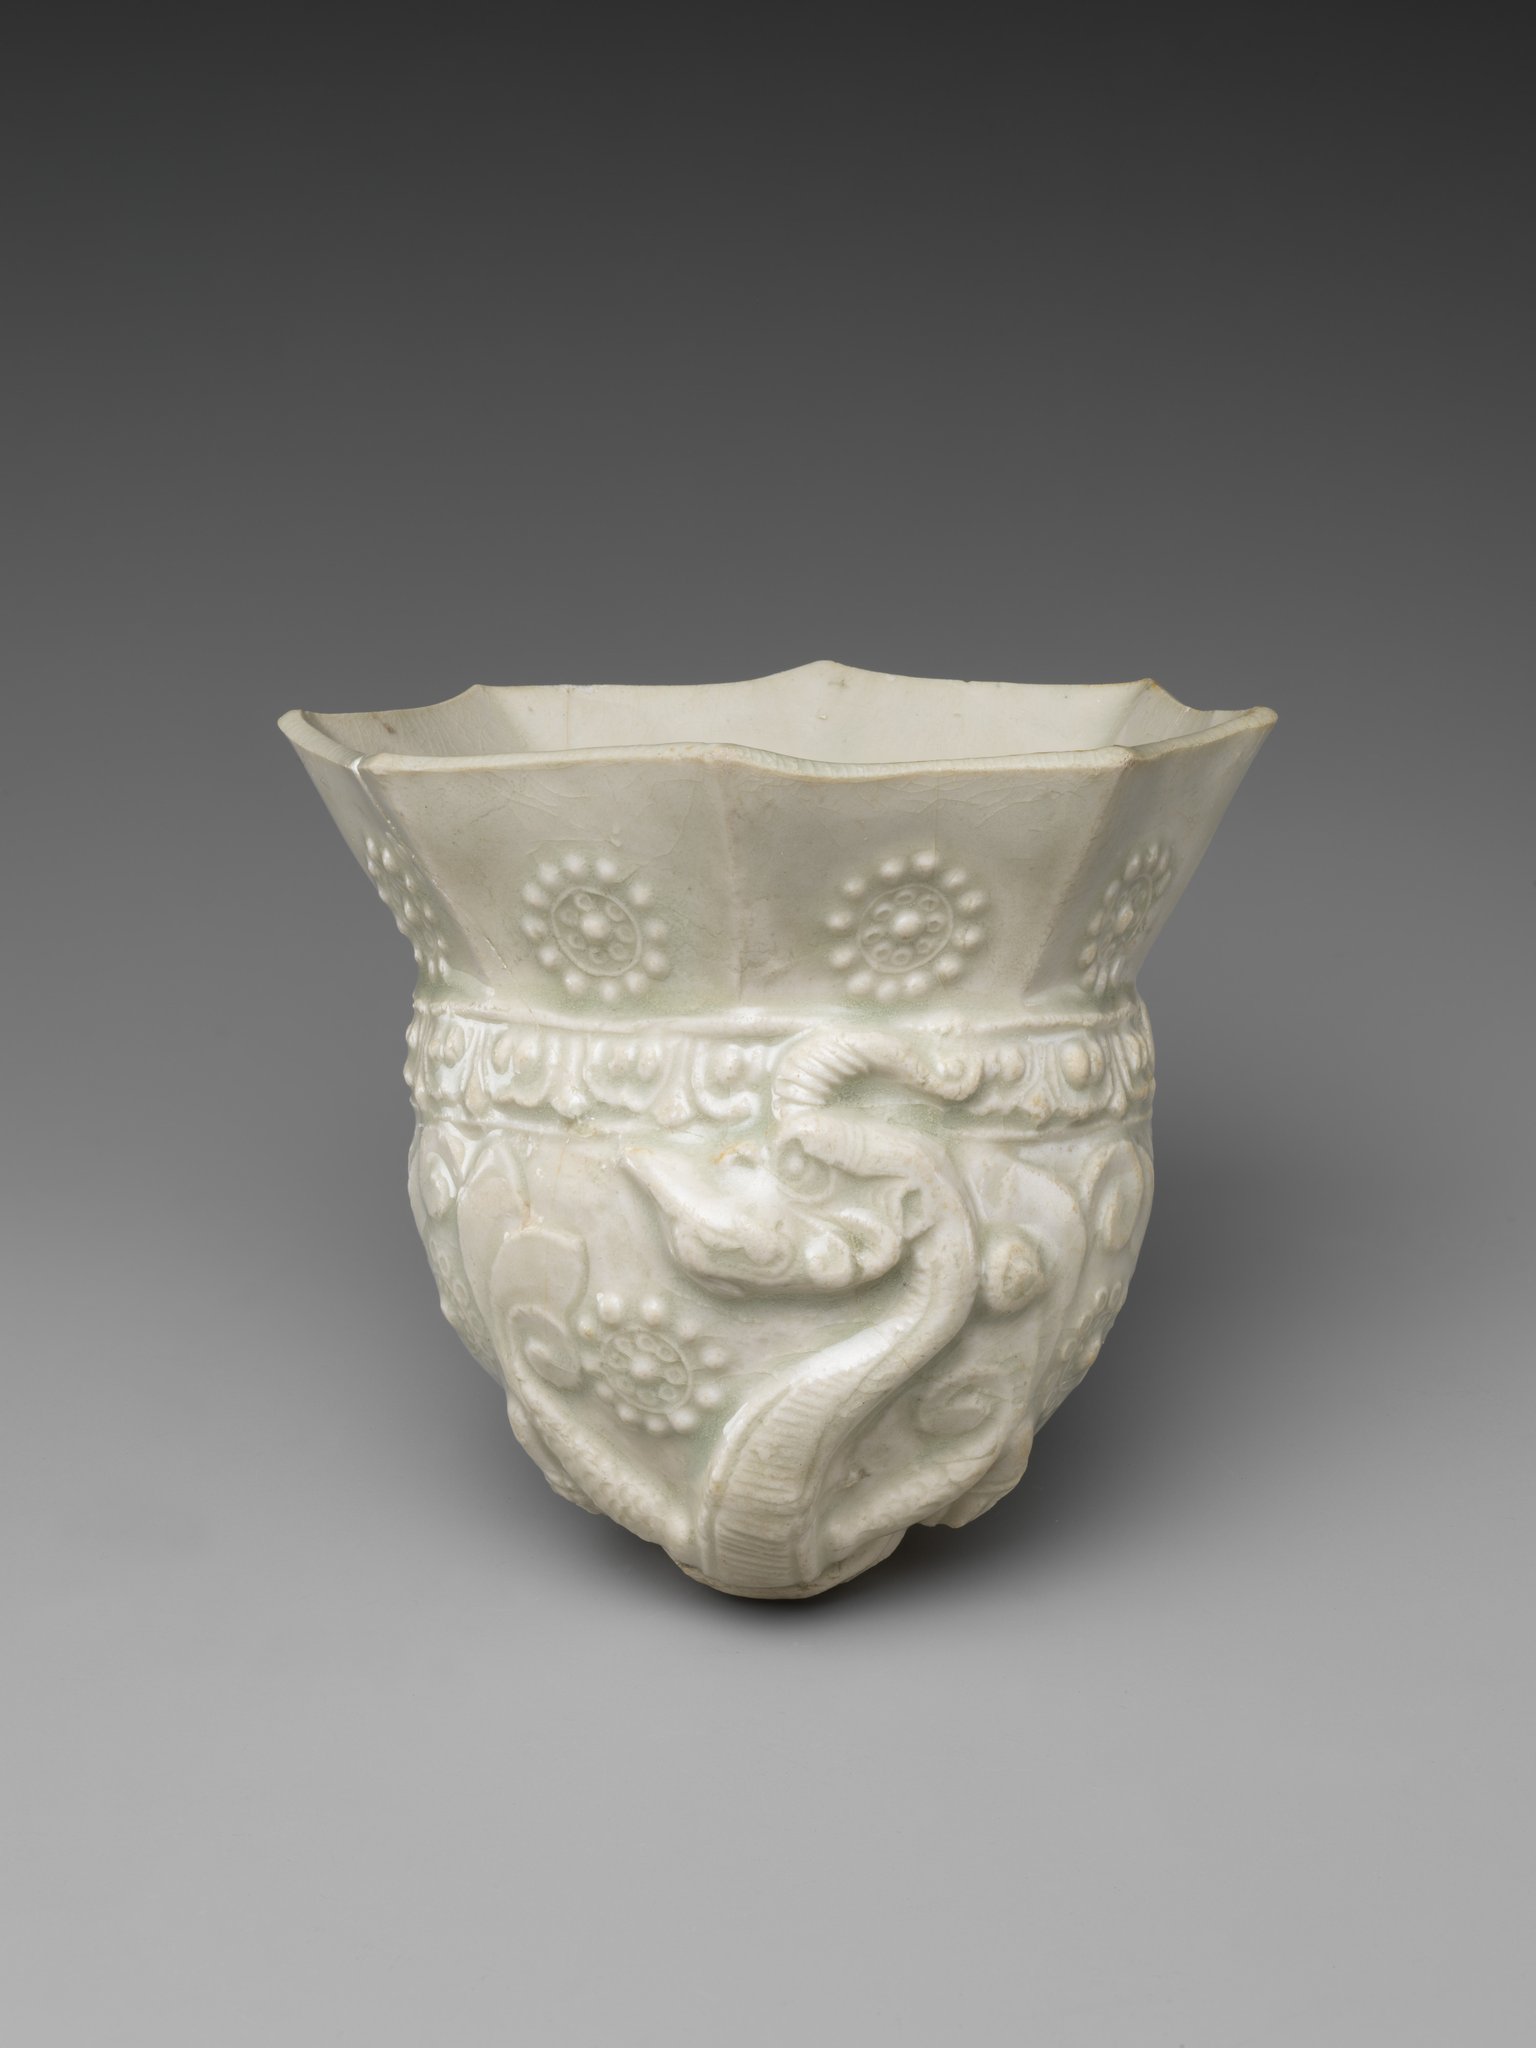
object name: cup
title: Cup modeled after a rhyton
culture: chinese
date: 567-600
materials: glaze, stoneware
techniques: relief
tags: dragons